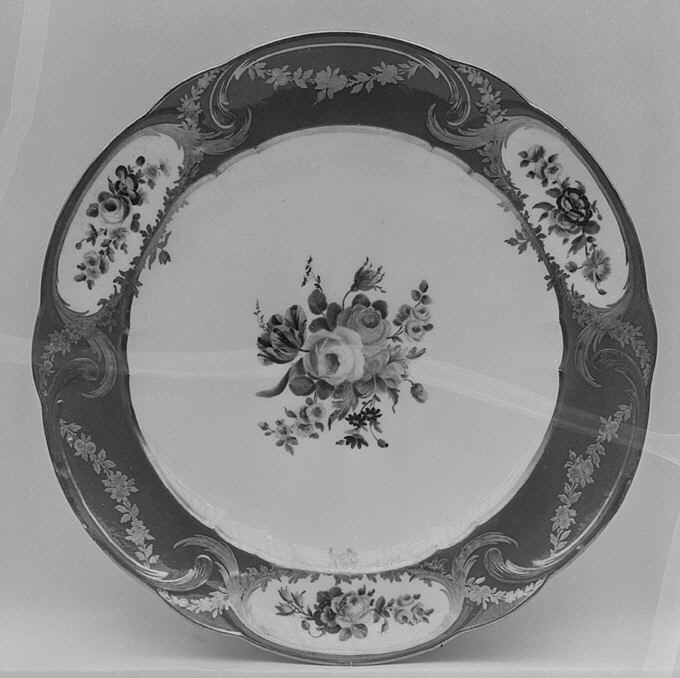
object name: plate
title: Plate (Assiette à palmes) (1 of 102) (part of a service)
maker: sèvres manufactory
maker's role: manufactory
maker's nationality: french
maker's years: 1740-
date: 1772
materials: soft paste porcelain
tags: roses